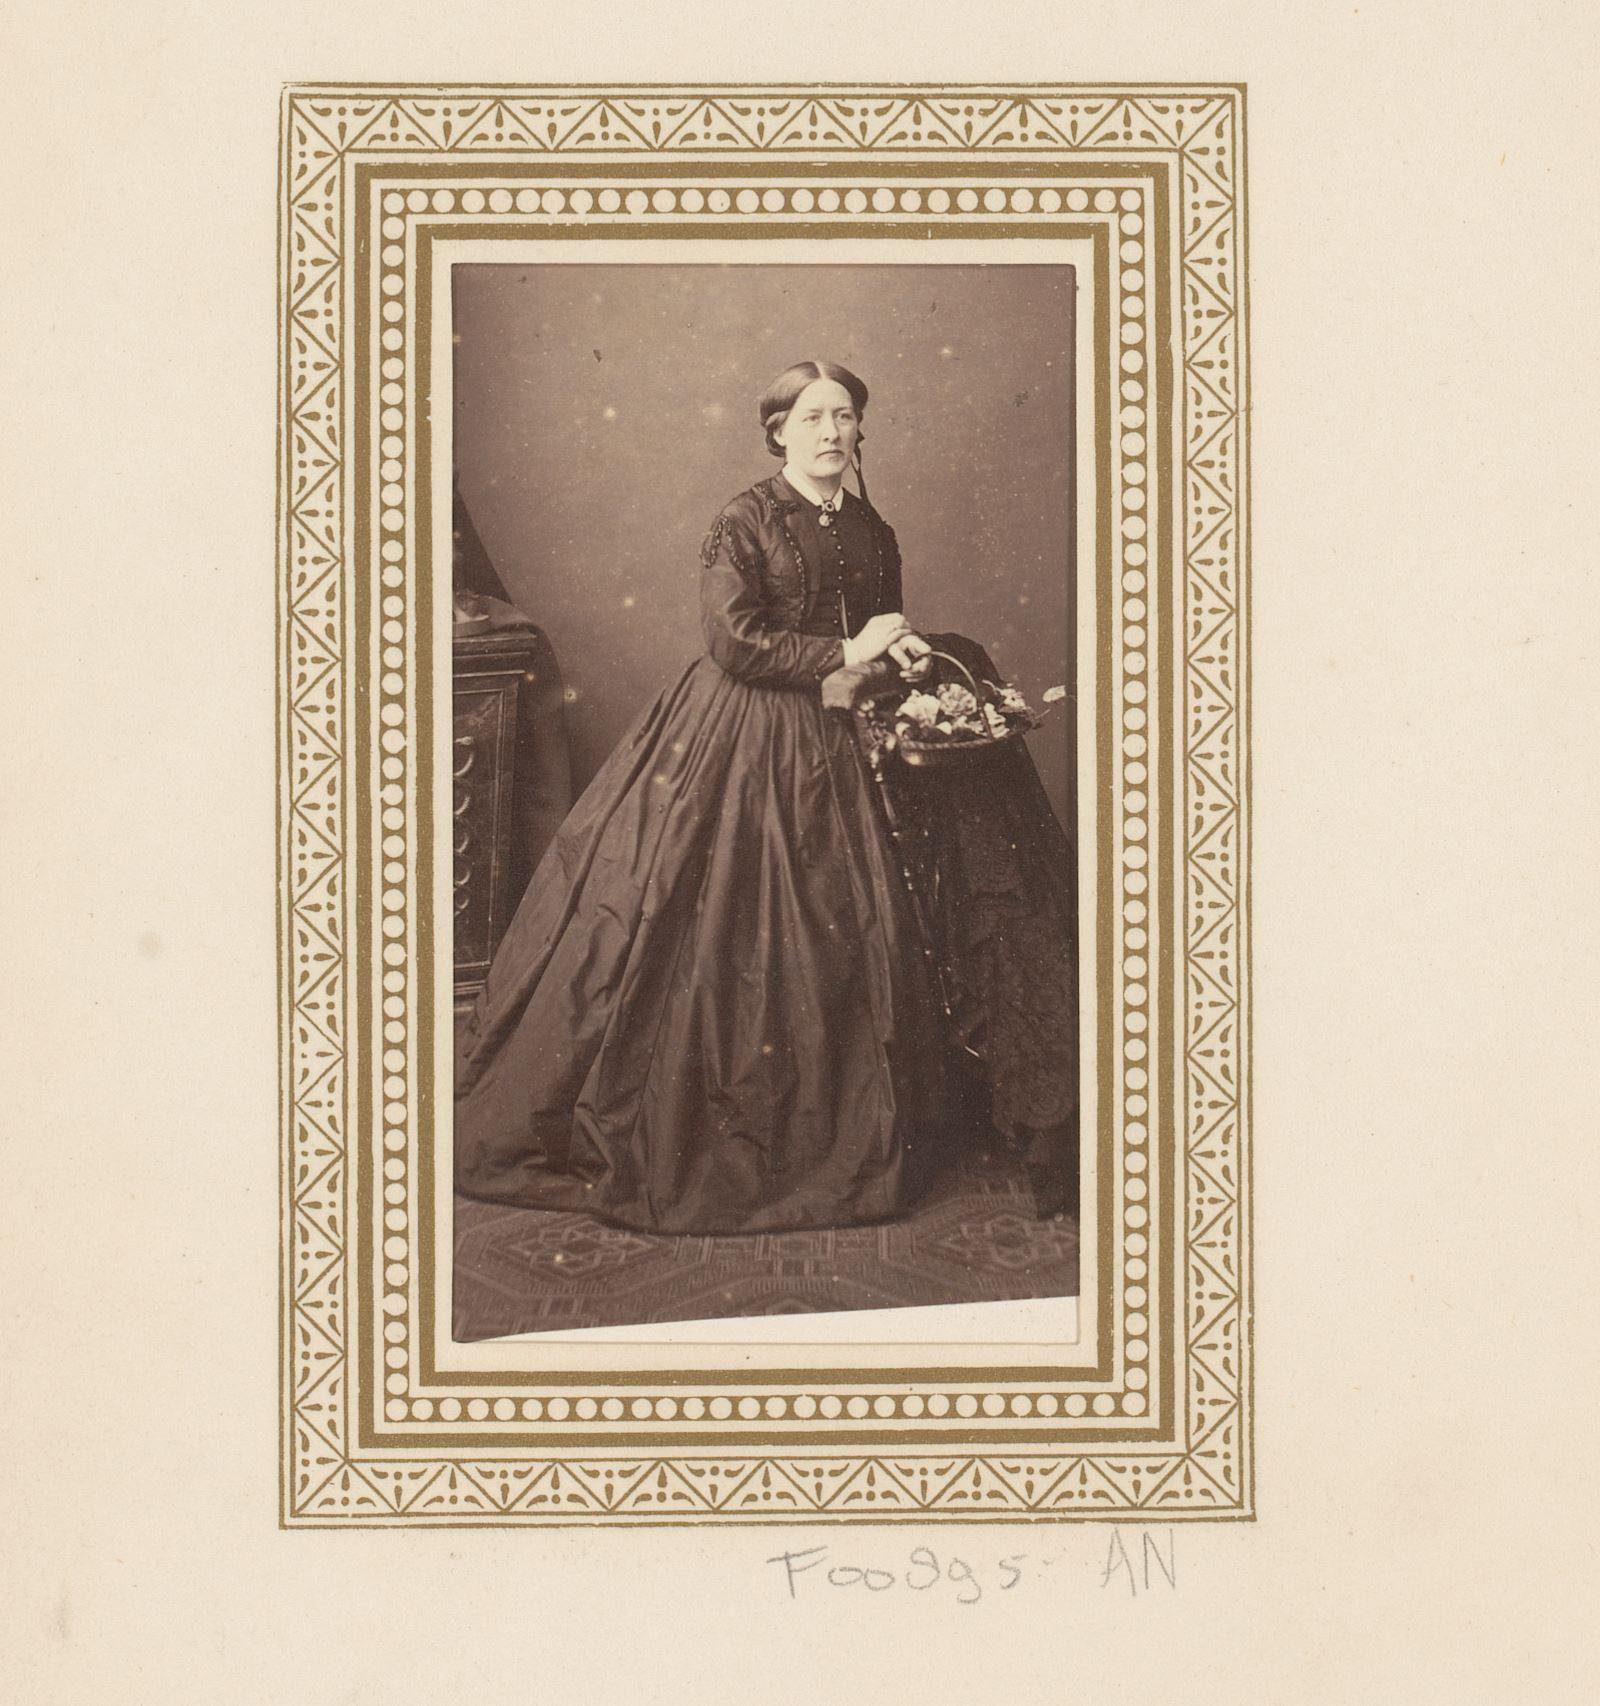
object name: album leaf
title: Portret van een staande vrouw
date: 1863-1875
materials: cardboard, photographic support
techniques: albumen print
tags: historical persons, standing figure - aa - female human figure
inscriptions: inscription: ‘G & R Lavis/ Photographers &/ Miniature Painters/ 135, Regent St/ W./ and at/ 42, Termnus Place/ Eastbourne’